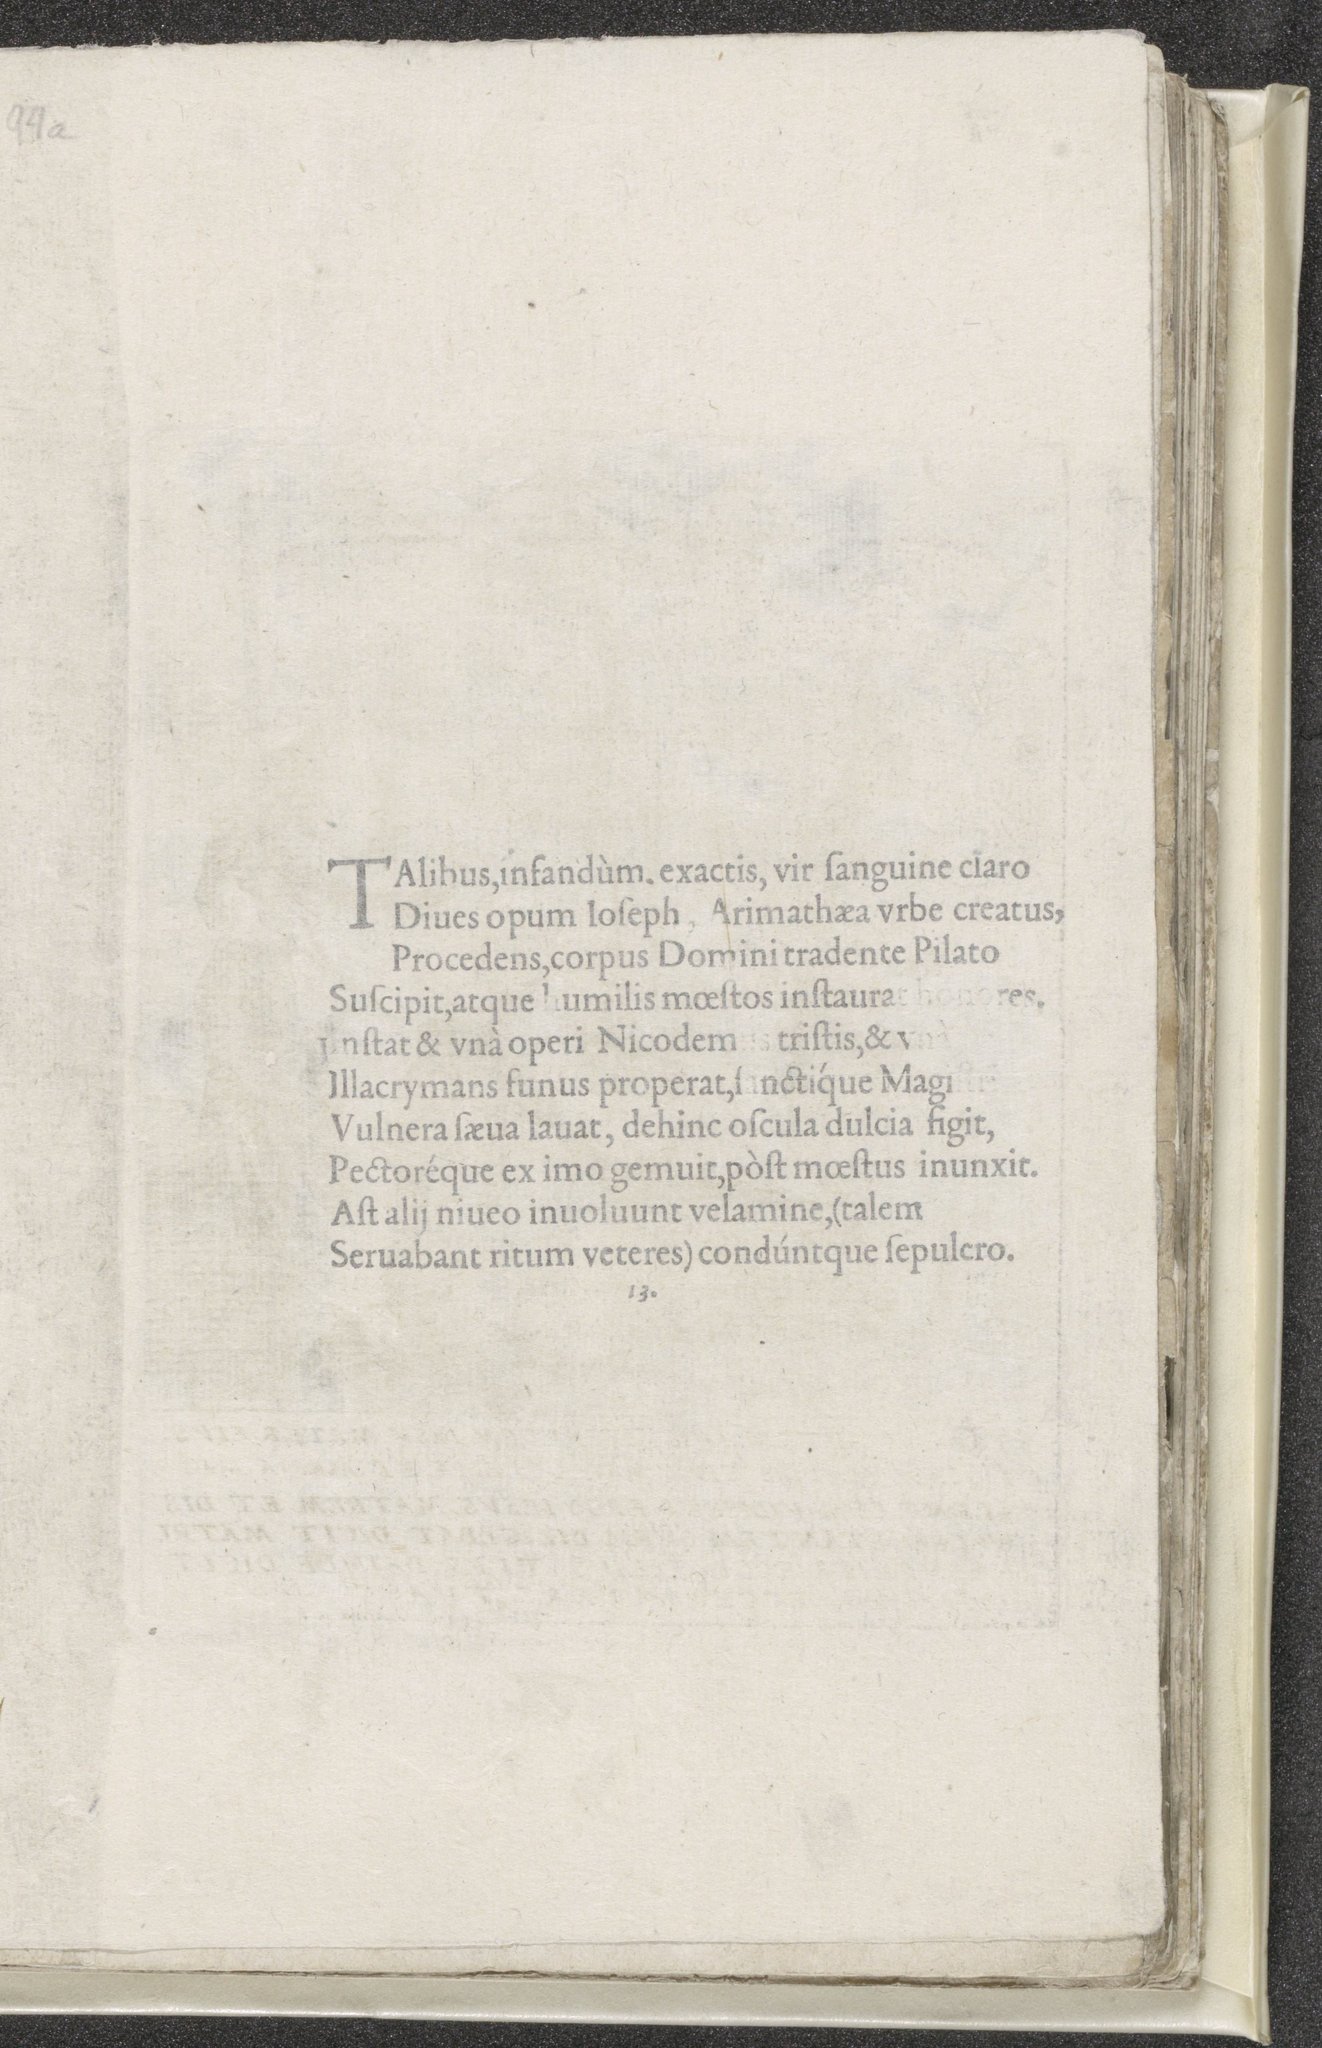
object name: album leaf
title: Mnimata Dominicae Passionis Historiam Necisque Nostrae Mortem Complexa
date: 1572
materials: paper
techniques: letterpress printing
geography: antwerp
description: Tijdens de restauratie in 1988 bleek dat op de achterzijde van de prenten van de Passie-serie van Wierix Latijnse teksten in boekdruk staan. Deze vormen, wanneer op de juiste wijze in boekvorm gebonden (wat nu in het Heemskerck-album niet het geval is), een toelichting op de passievoorstellingen. Om de teksten zichtbaar te laten zijn de prenten bij de restauratie niet meer met de achterzijde op elkaar geplakt.